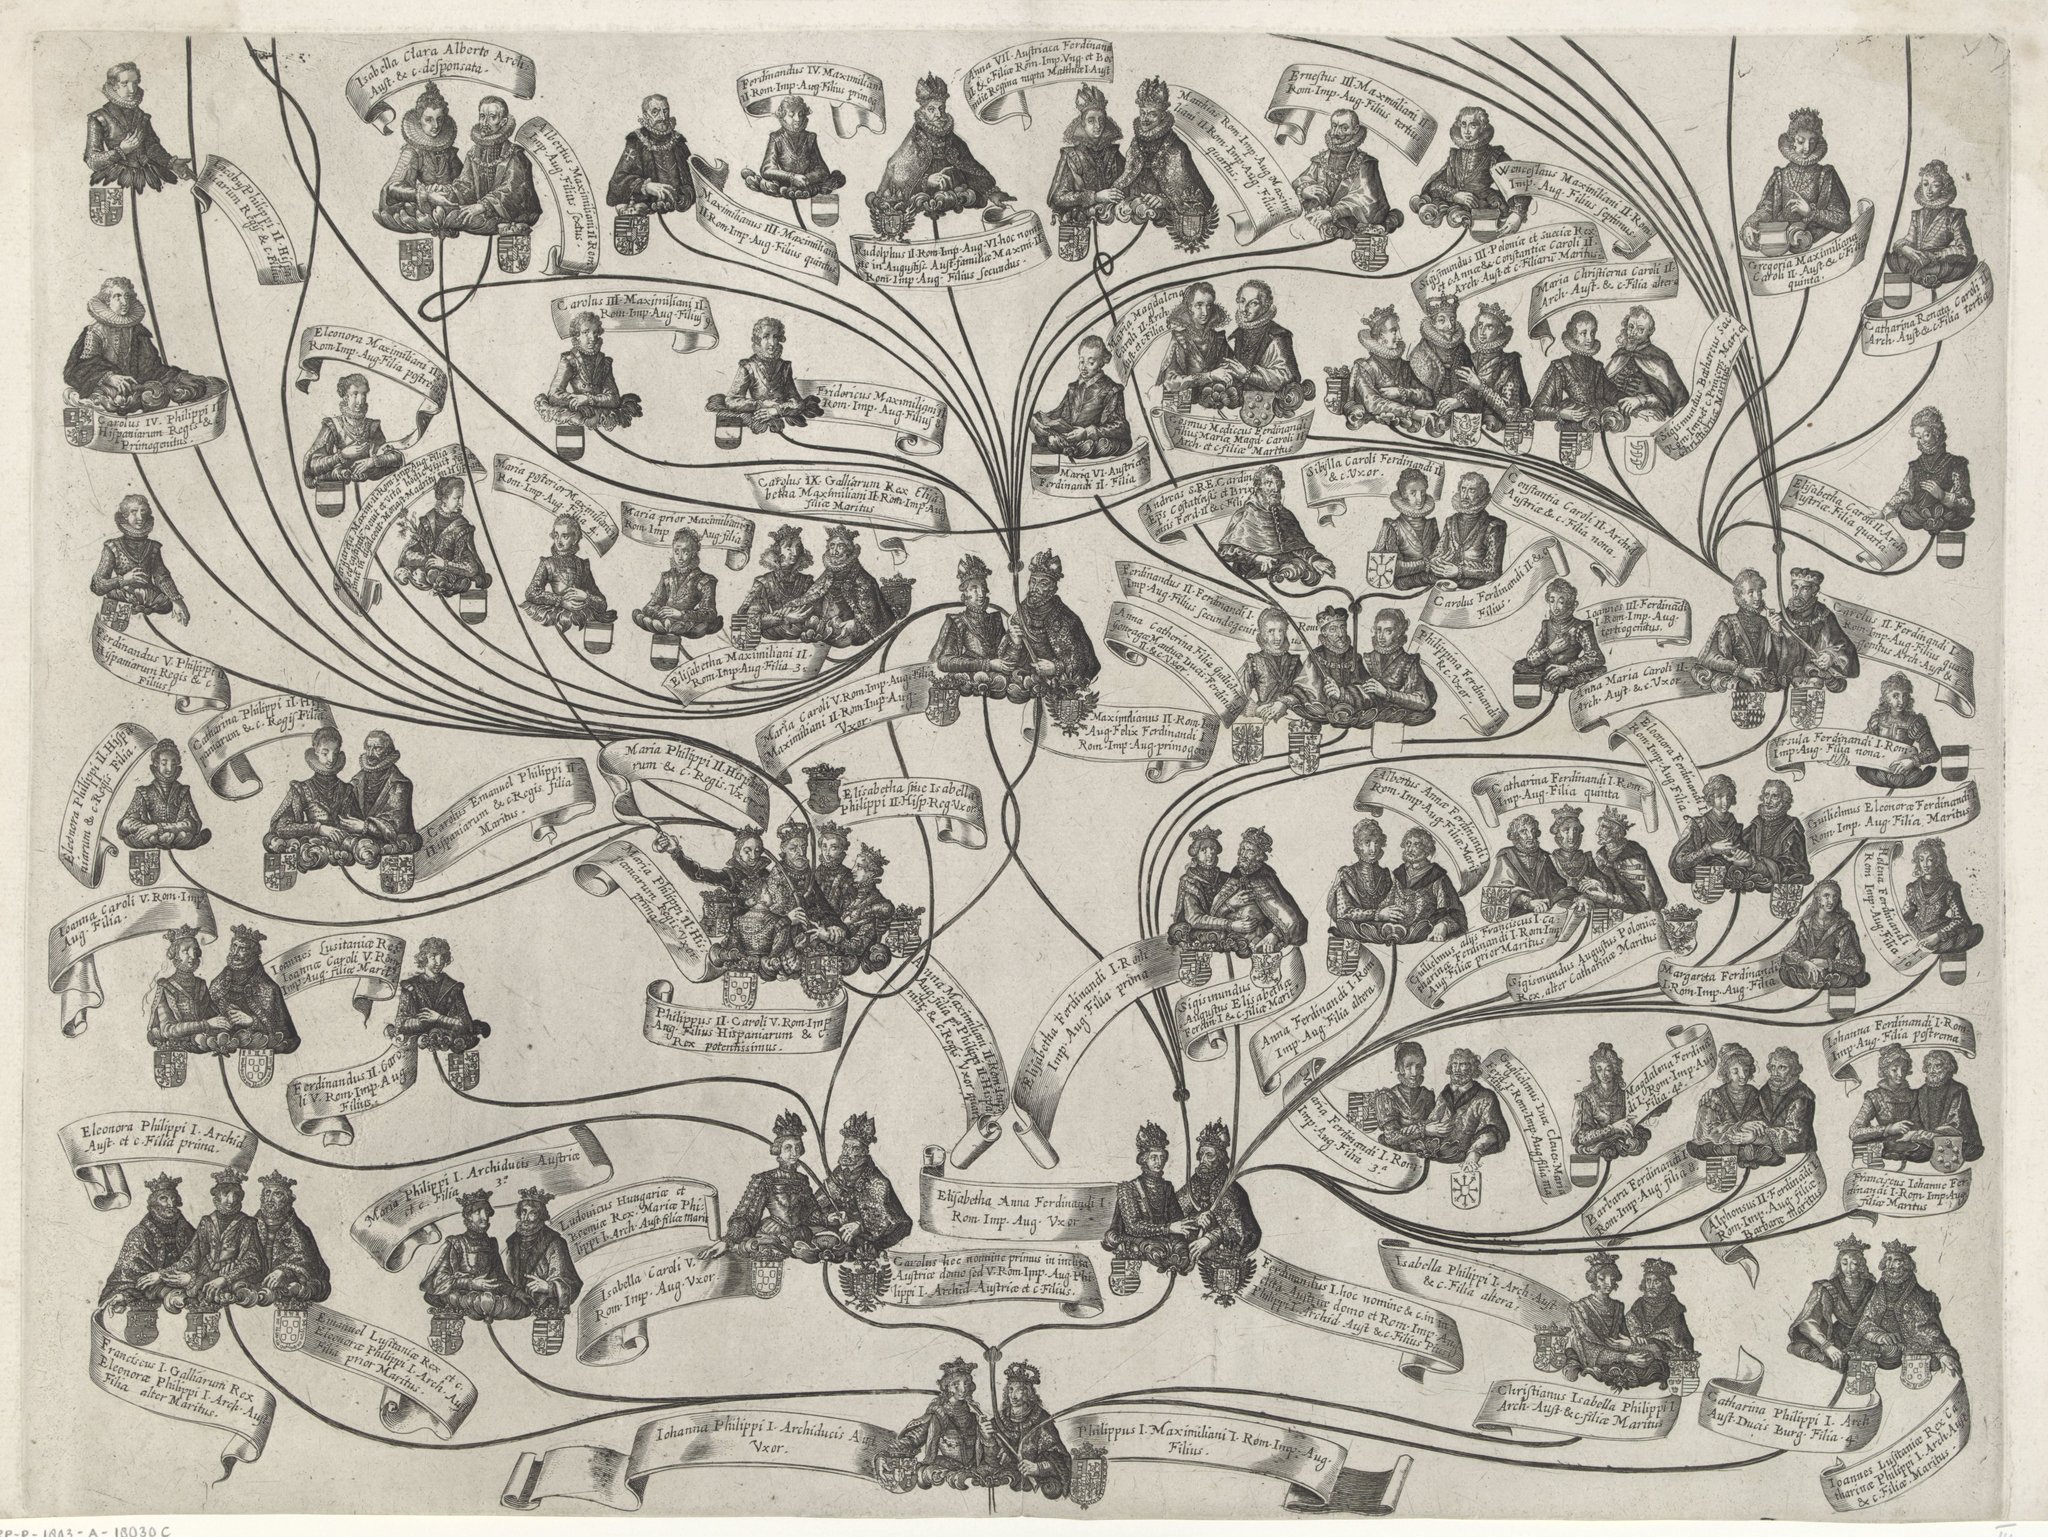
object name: print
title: Stamboom van het Habsburgse huis, serie A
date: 1629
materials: paper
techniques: engraving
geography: prague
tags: family lineage, pedigree, genealogical tree or table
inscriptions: collector's mark: Lugt 2228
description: De prent behoort tot een serie bestaande uit zes prenten, waarvan één titelprent. De laatste prent is van de hand van een anonieme kunstenaar en de overige prenten zijn vervaardigd door Aegidius Sadeler.